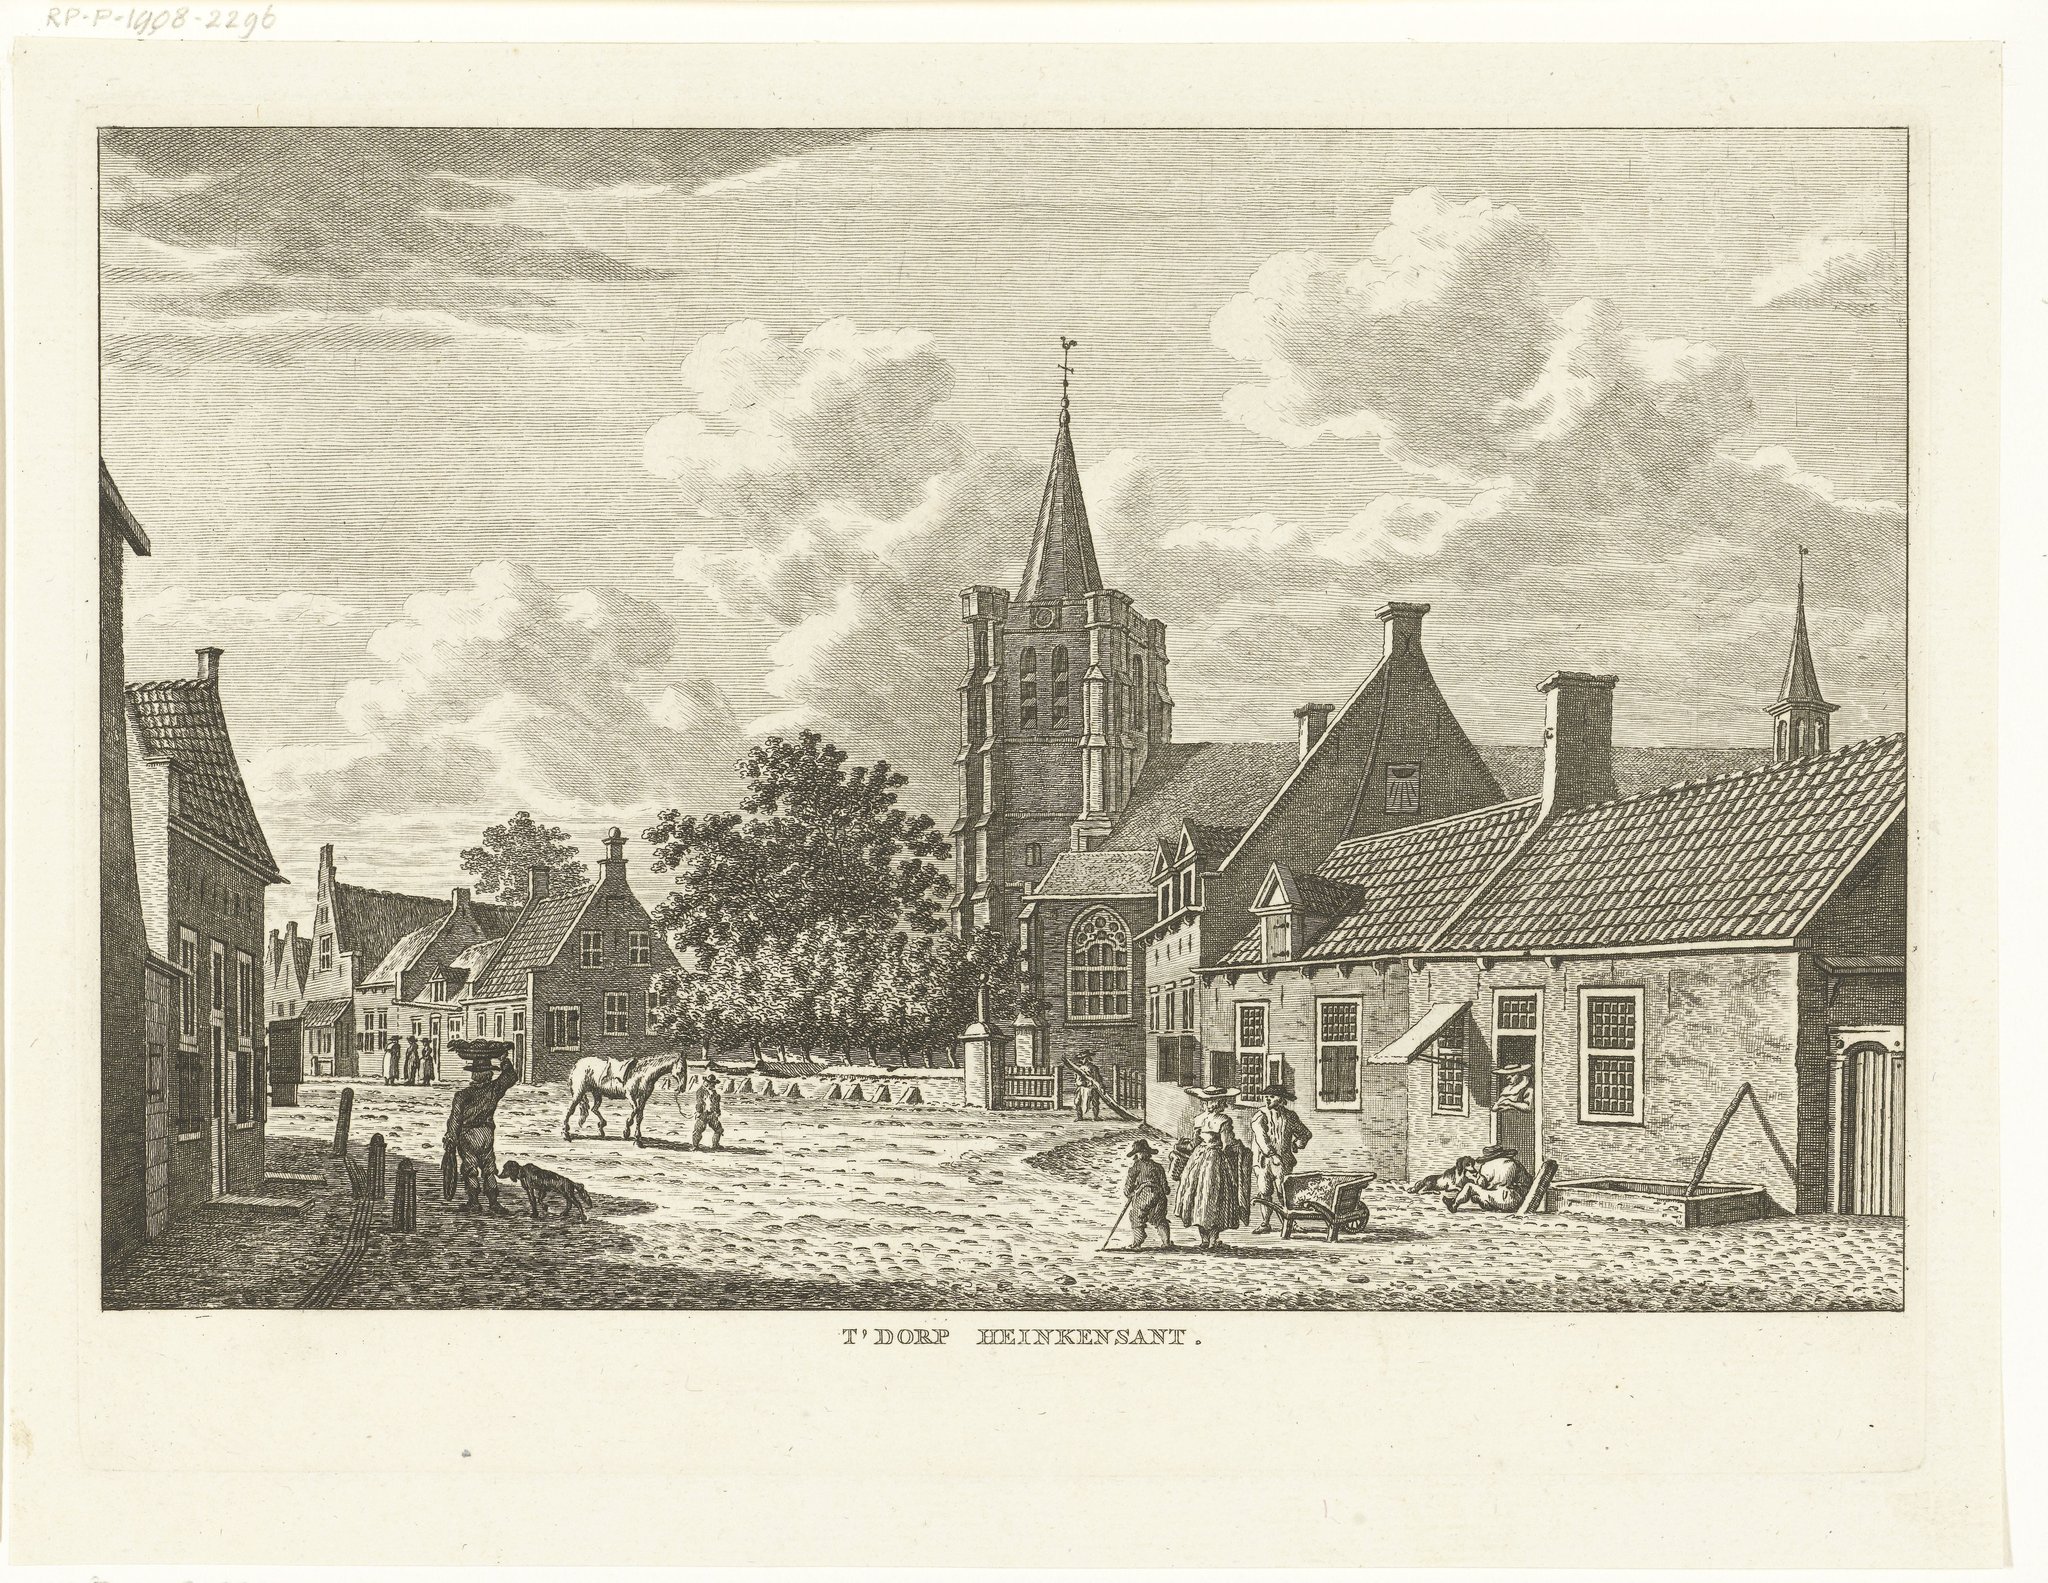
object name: print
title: T' Dorp Heinkensant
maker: carel frederik bendorp (i)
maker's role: print maker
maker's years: 1736-1814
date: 1786-1792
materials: paper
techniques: etching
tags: village, church (exterior)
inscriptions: collector's mark: Lugt 2228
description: Prent uit: Vaderlandsche gezichten, of afbeeldingen van den tegenwoordigen staat der Vereenigde Nederlanden (…). Amsterdam: Hendrik Gartman, Willem Vermandel en Jan Willem Smit, 1786-1792. Uitgegeven in afleveringen met ieder een eigen bifolium en inhoudsopgave. Alle prenten in deze publicatie zijn gegraveerd door Carel Frederik Bendorp (I) en, in de meeste gevallen, gebaseerd op tekeningen van Jan Bulthuis.